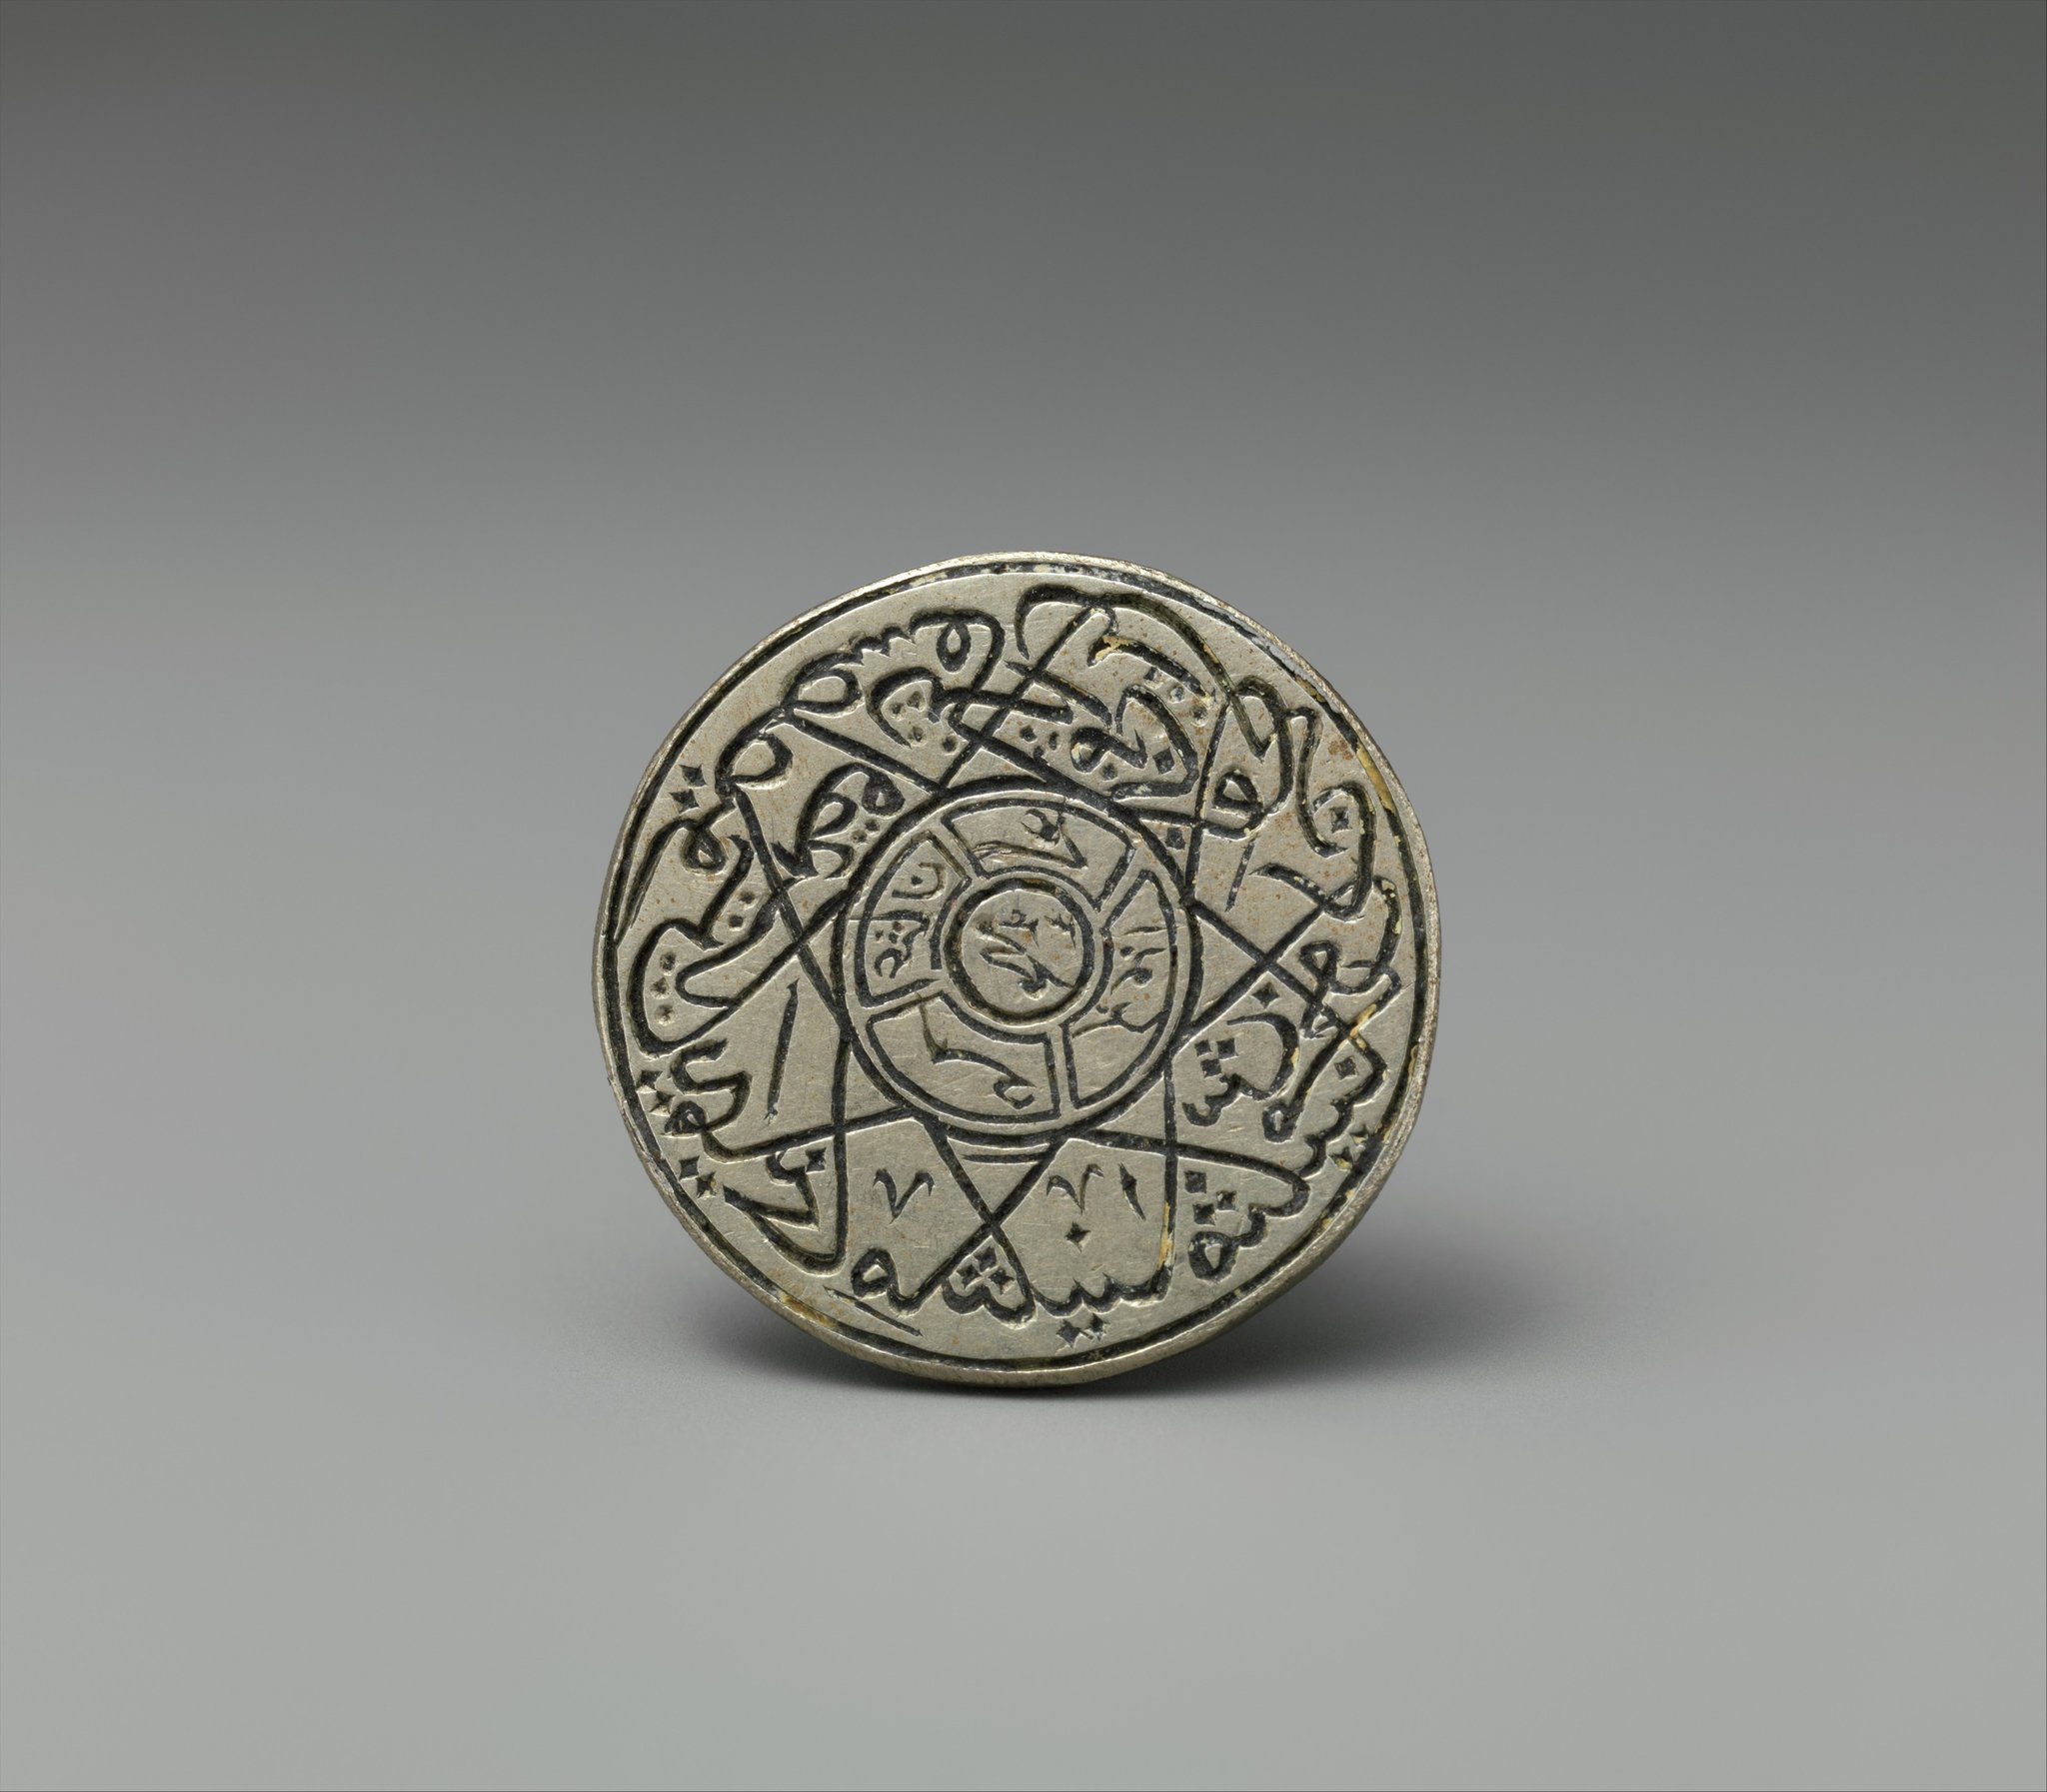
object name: seal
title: Stamp Seal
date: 1701-1800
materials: silver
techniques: casting, engraving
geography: turkey